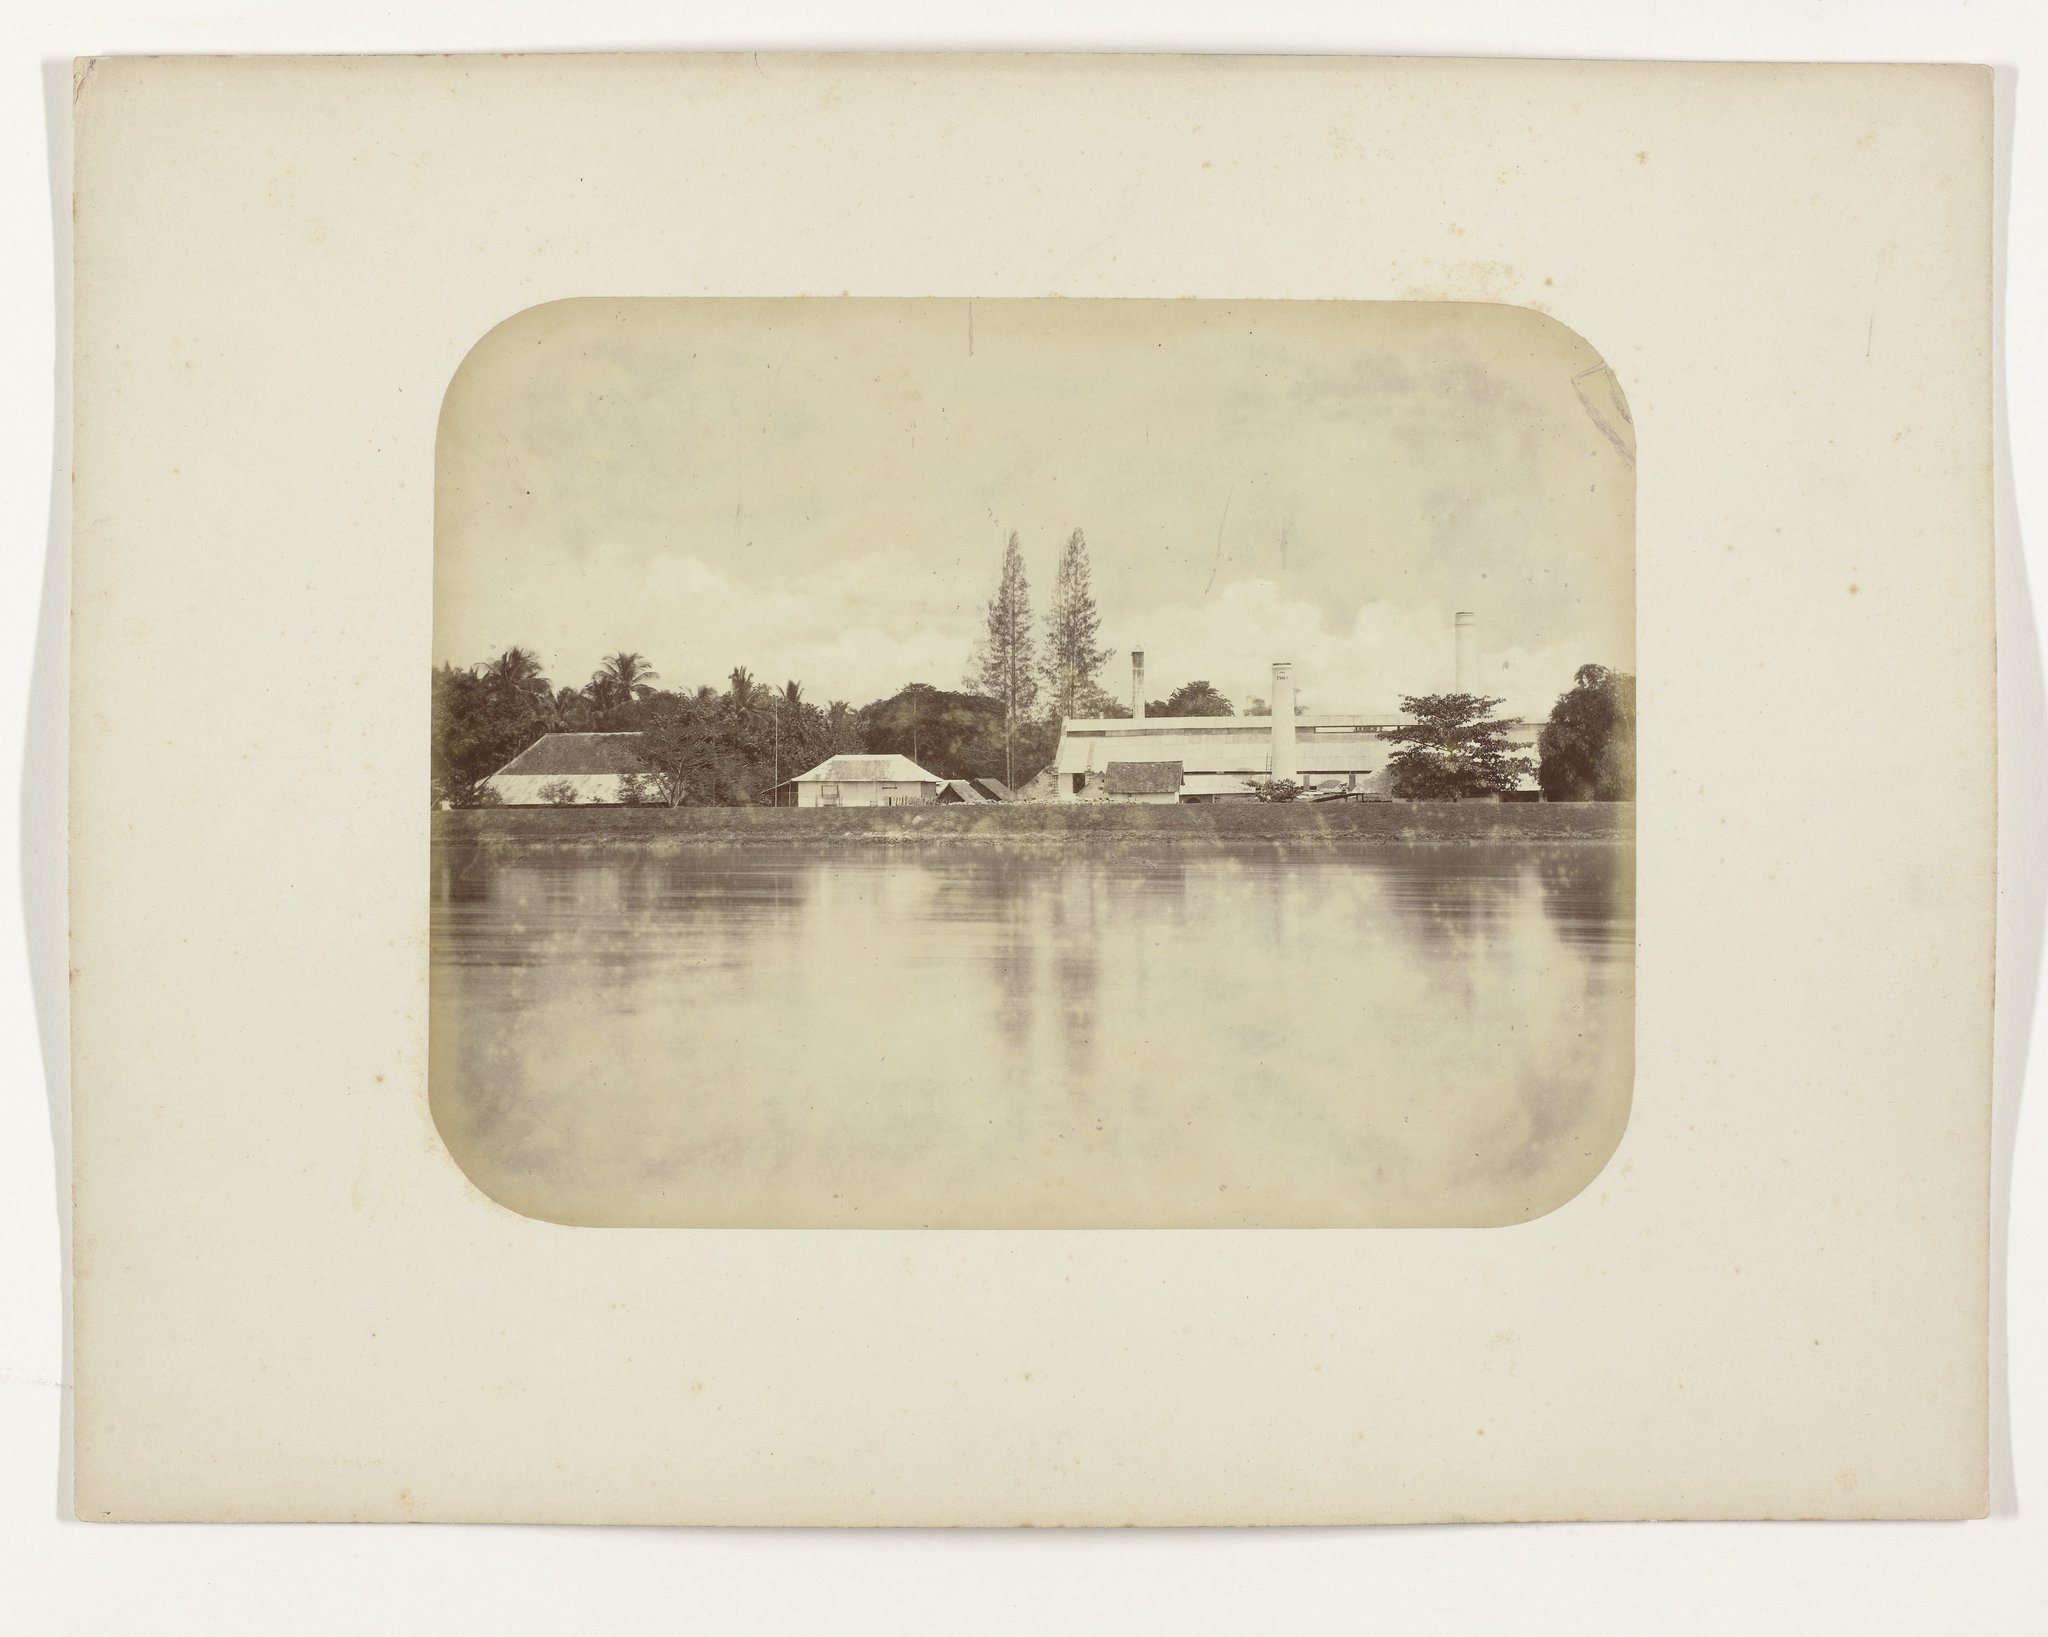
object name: photograph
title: De suikerfabriek Ponen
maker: herman salzwedel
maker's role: fotograaf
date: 1876-1884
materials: photographic support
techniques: albumen print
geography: surabaya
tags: utrecht, the hague, colonial system, factory-building, (non-fruit) products of plants or trees: sugarcane, java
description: De suikerfabriek Ponen met drie schoorstenen met op de middelste schoorsteen Ponen 1884 (!). Op de voorgrond een rivier. Onderdeel van het fotoalbum door de Soerabayasche Vereeniging van Suikerfabrikanten aangeboden aan Frederik Beyerinck, resident van Soerabaja.